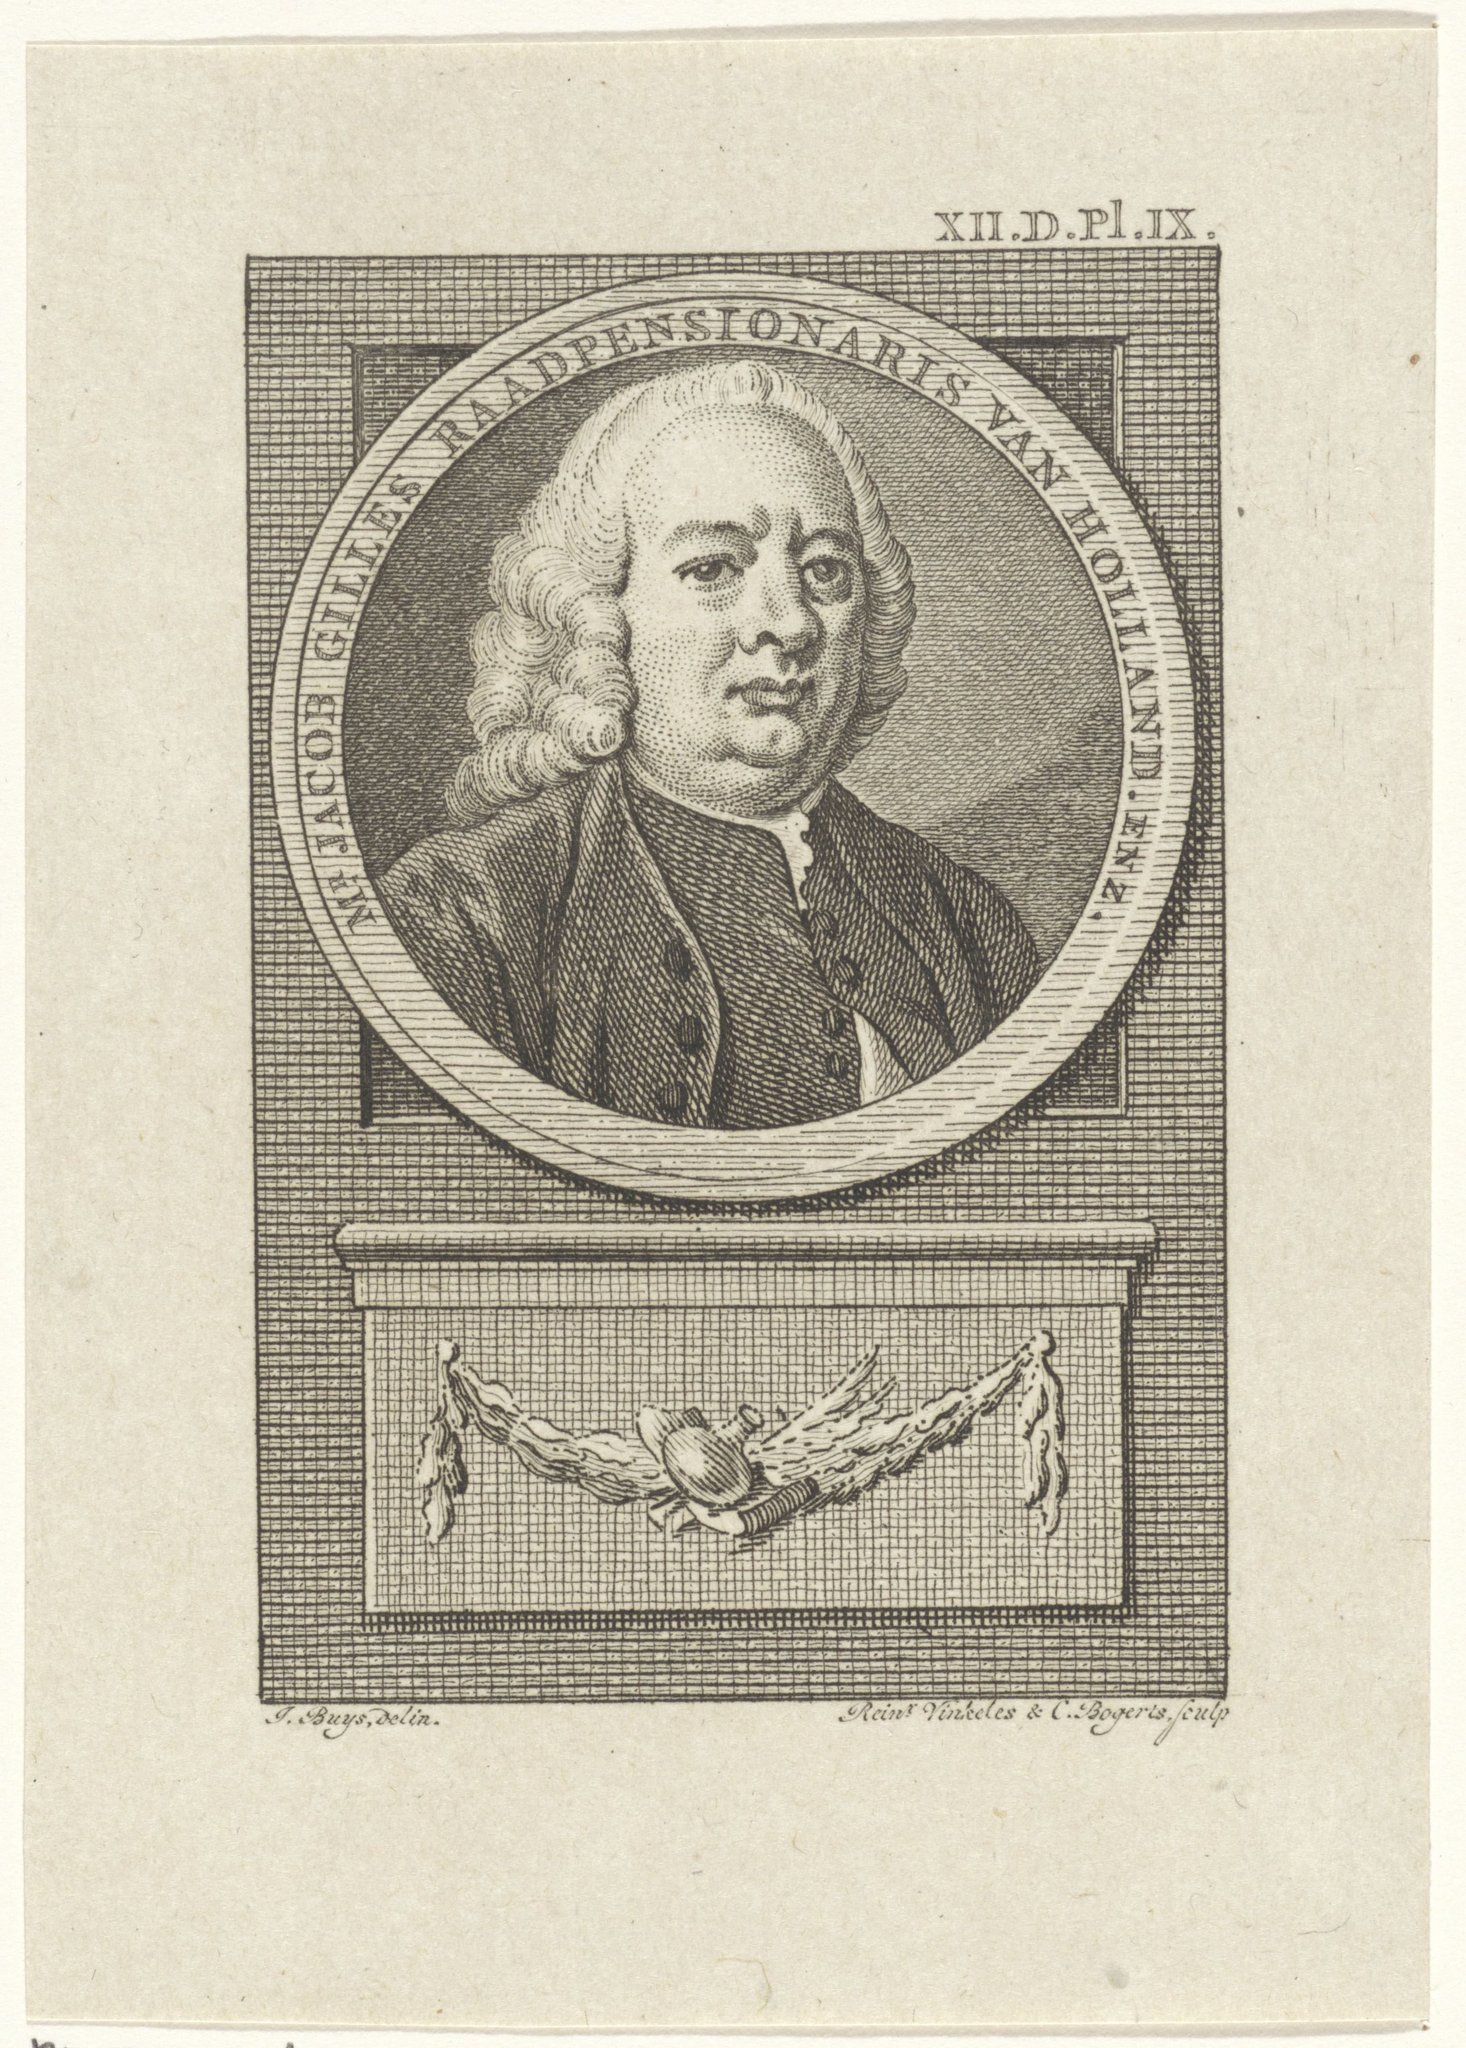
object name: book illustration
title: Portret van Jacob Gilles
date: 1783-1795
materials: paper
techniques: engraving, etching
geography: amsterdam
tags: kollum, rijswijk, raadpensionaris, jacob gilles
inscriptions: collector's mark: Lugt 2228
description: Prent gebruikt in: Fokke, Jan. Geschiedenissen der Vereenigde Nederlanden voor de vaderlandsche jeugd Ie-XXVste deel. Amsterdam: Johannes Allart, 1783-1795. Deel XII.